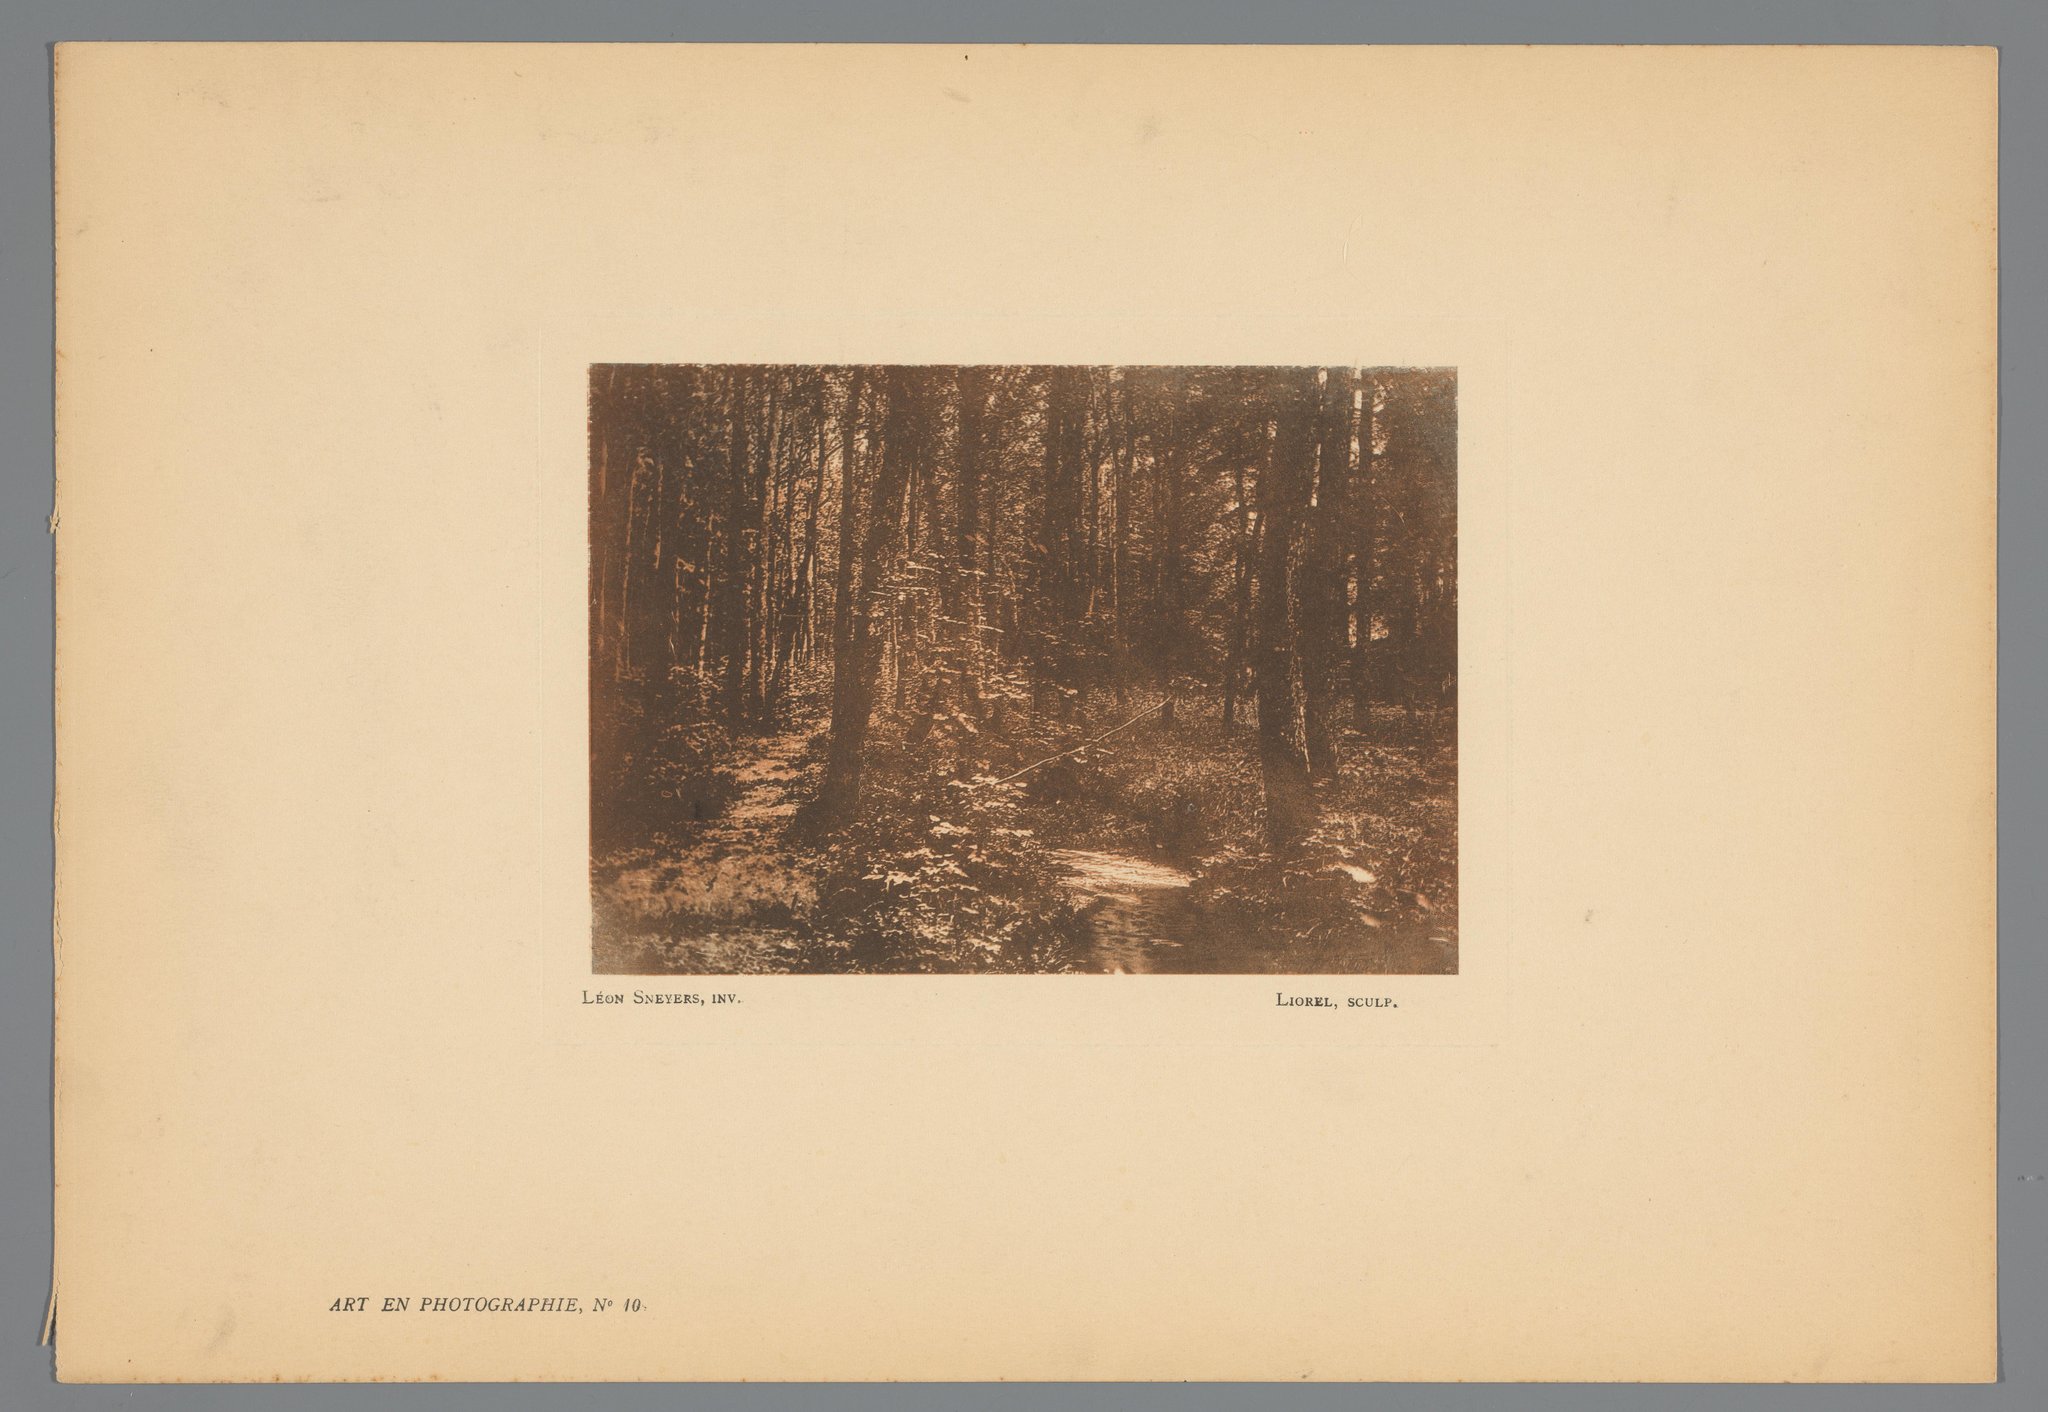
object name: photomechanical print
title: Bos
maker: léon sneyers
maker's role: architect, fotograaf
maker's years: 1877-1949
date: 1896-1901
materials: paper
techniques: photograph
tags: forest, wood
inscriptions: inscription: ‘ART EN PHOTOGRAPHIE, No 10’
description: Deze prent maakt deel uit van een omslag met 54 prenten op 52 bladen.